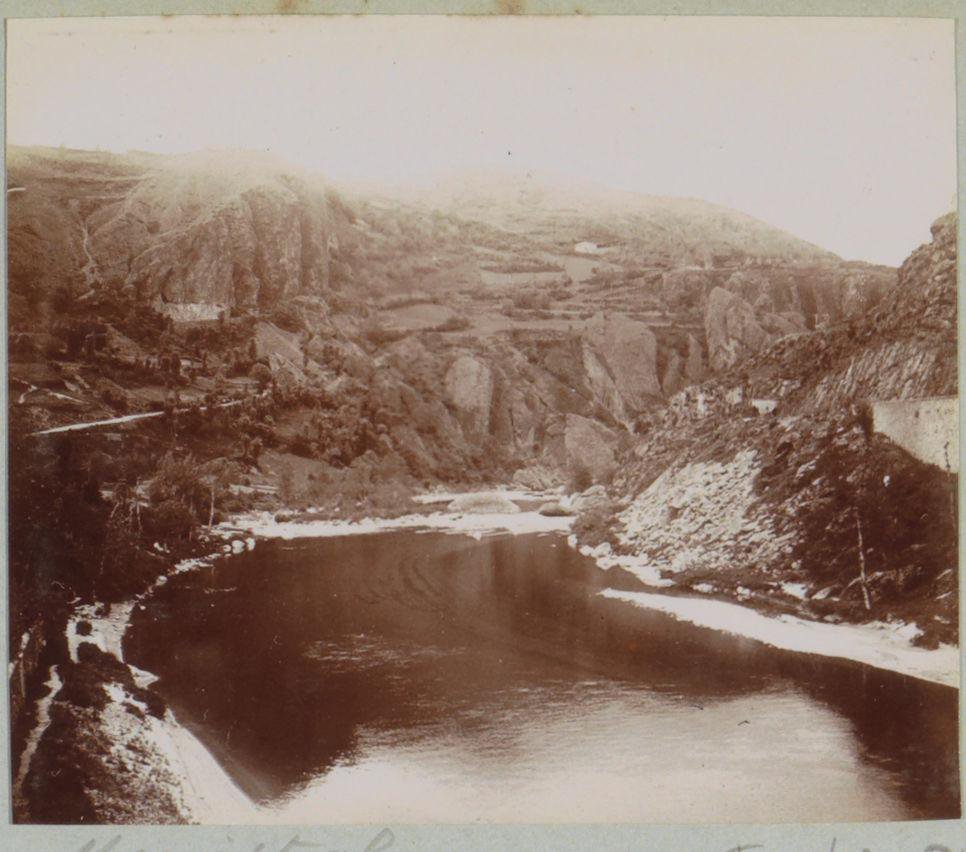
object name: photograph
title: Gezicht op de rivier bij Monistrol-d'Allier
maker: delizy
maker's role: manufacturer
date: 1902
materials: paper, photographic support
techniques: gelatin silver print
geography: monistrol-d'allier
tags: dry river, river bed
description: Onderdeel van Fotoalbum van een Franse amateurfotograaf met opnames van uitstapjes in Frankrijk, Spanje, België, Luxemburg en Nederland, de eerste automobielen en autoraces.